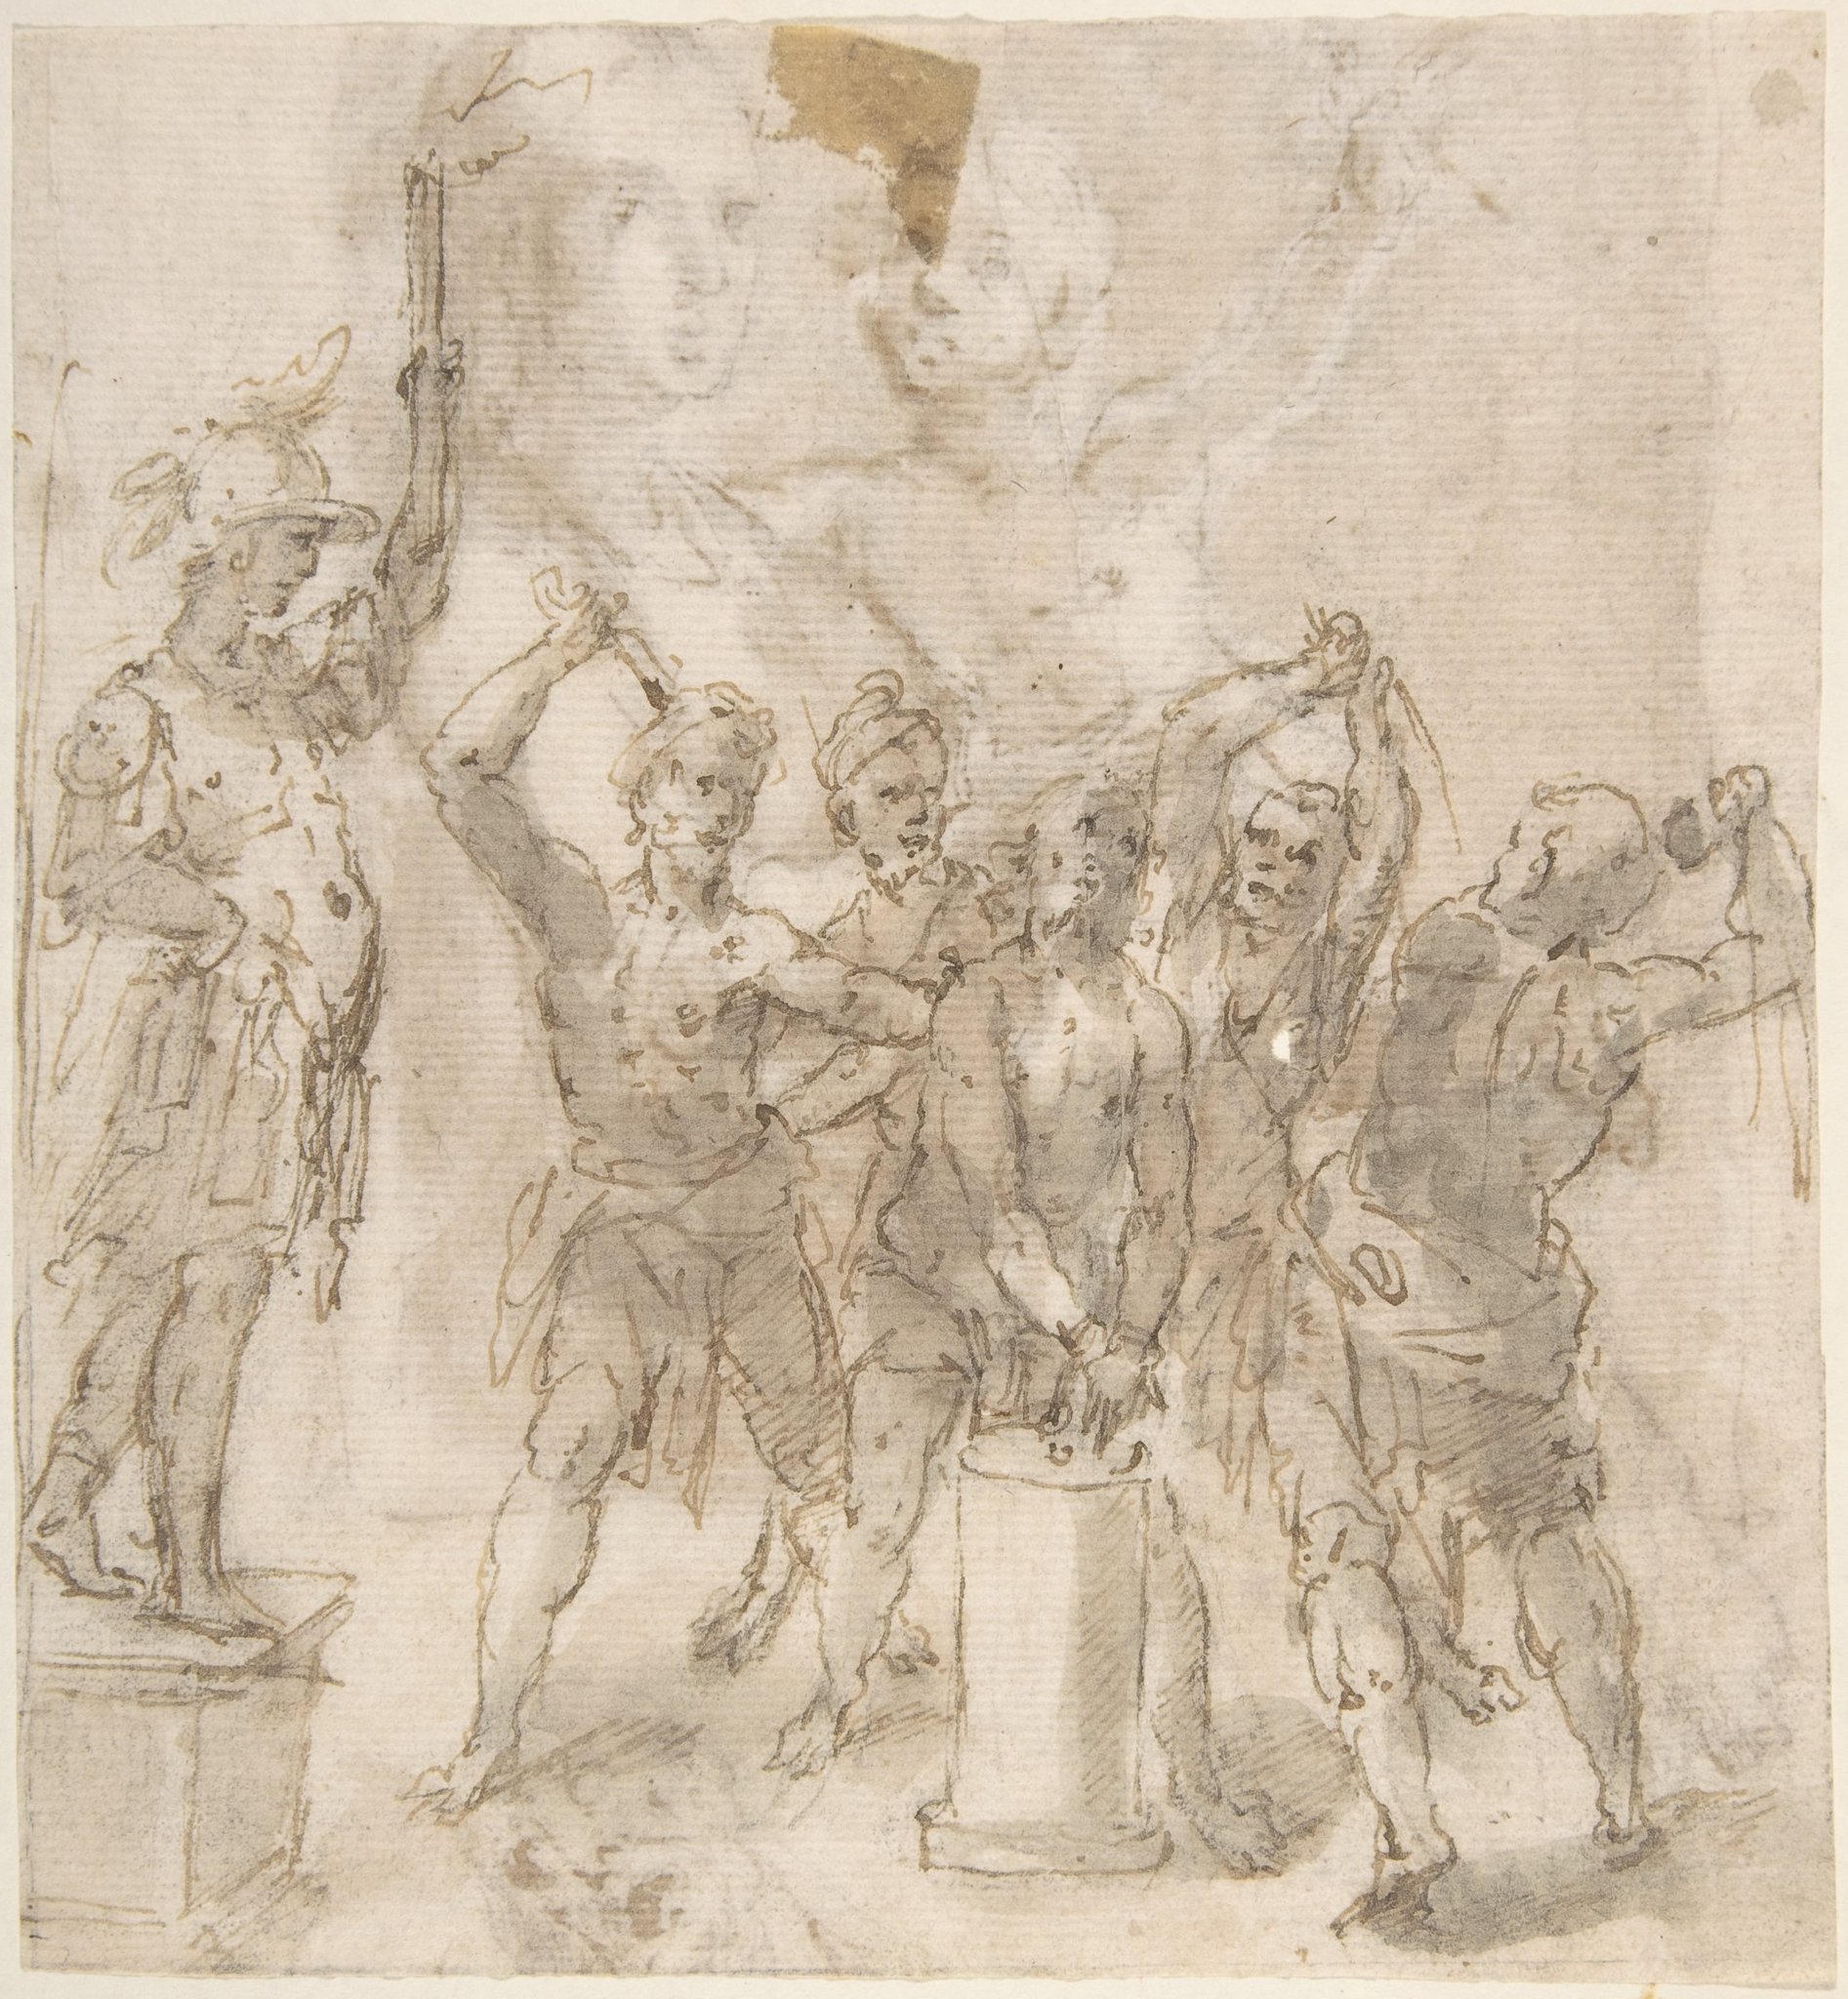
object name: drawing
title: The Flagellation of Christ (recto); Madonna and Child and Unrelated Figure Studies (verso)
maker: anonymous, spanish, school of seville, 17th century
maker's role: artist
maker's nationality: spanish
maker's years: 1600-1700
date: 1601-1700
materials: chalk, ink, paper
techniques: brush, pen, drawing, wash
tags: suffering,men,christ,madonna and child